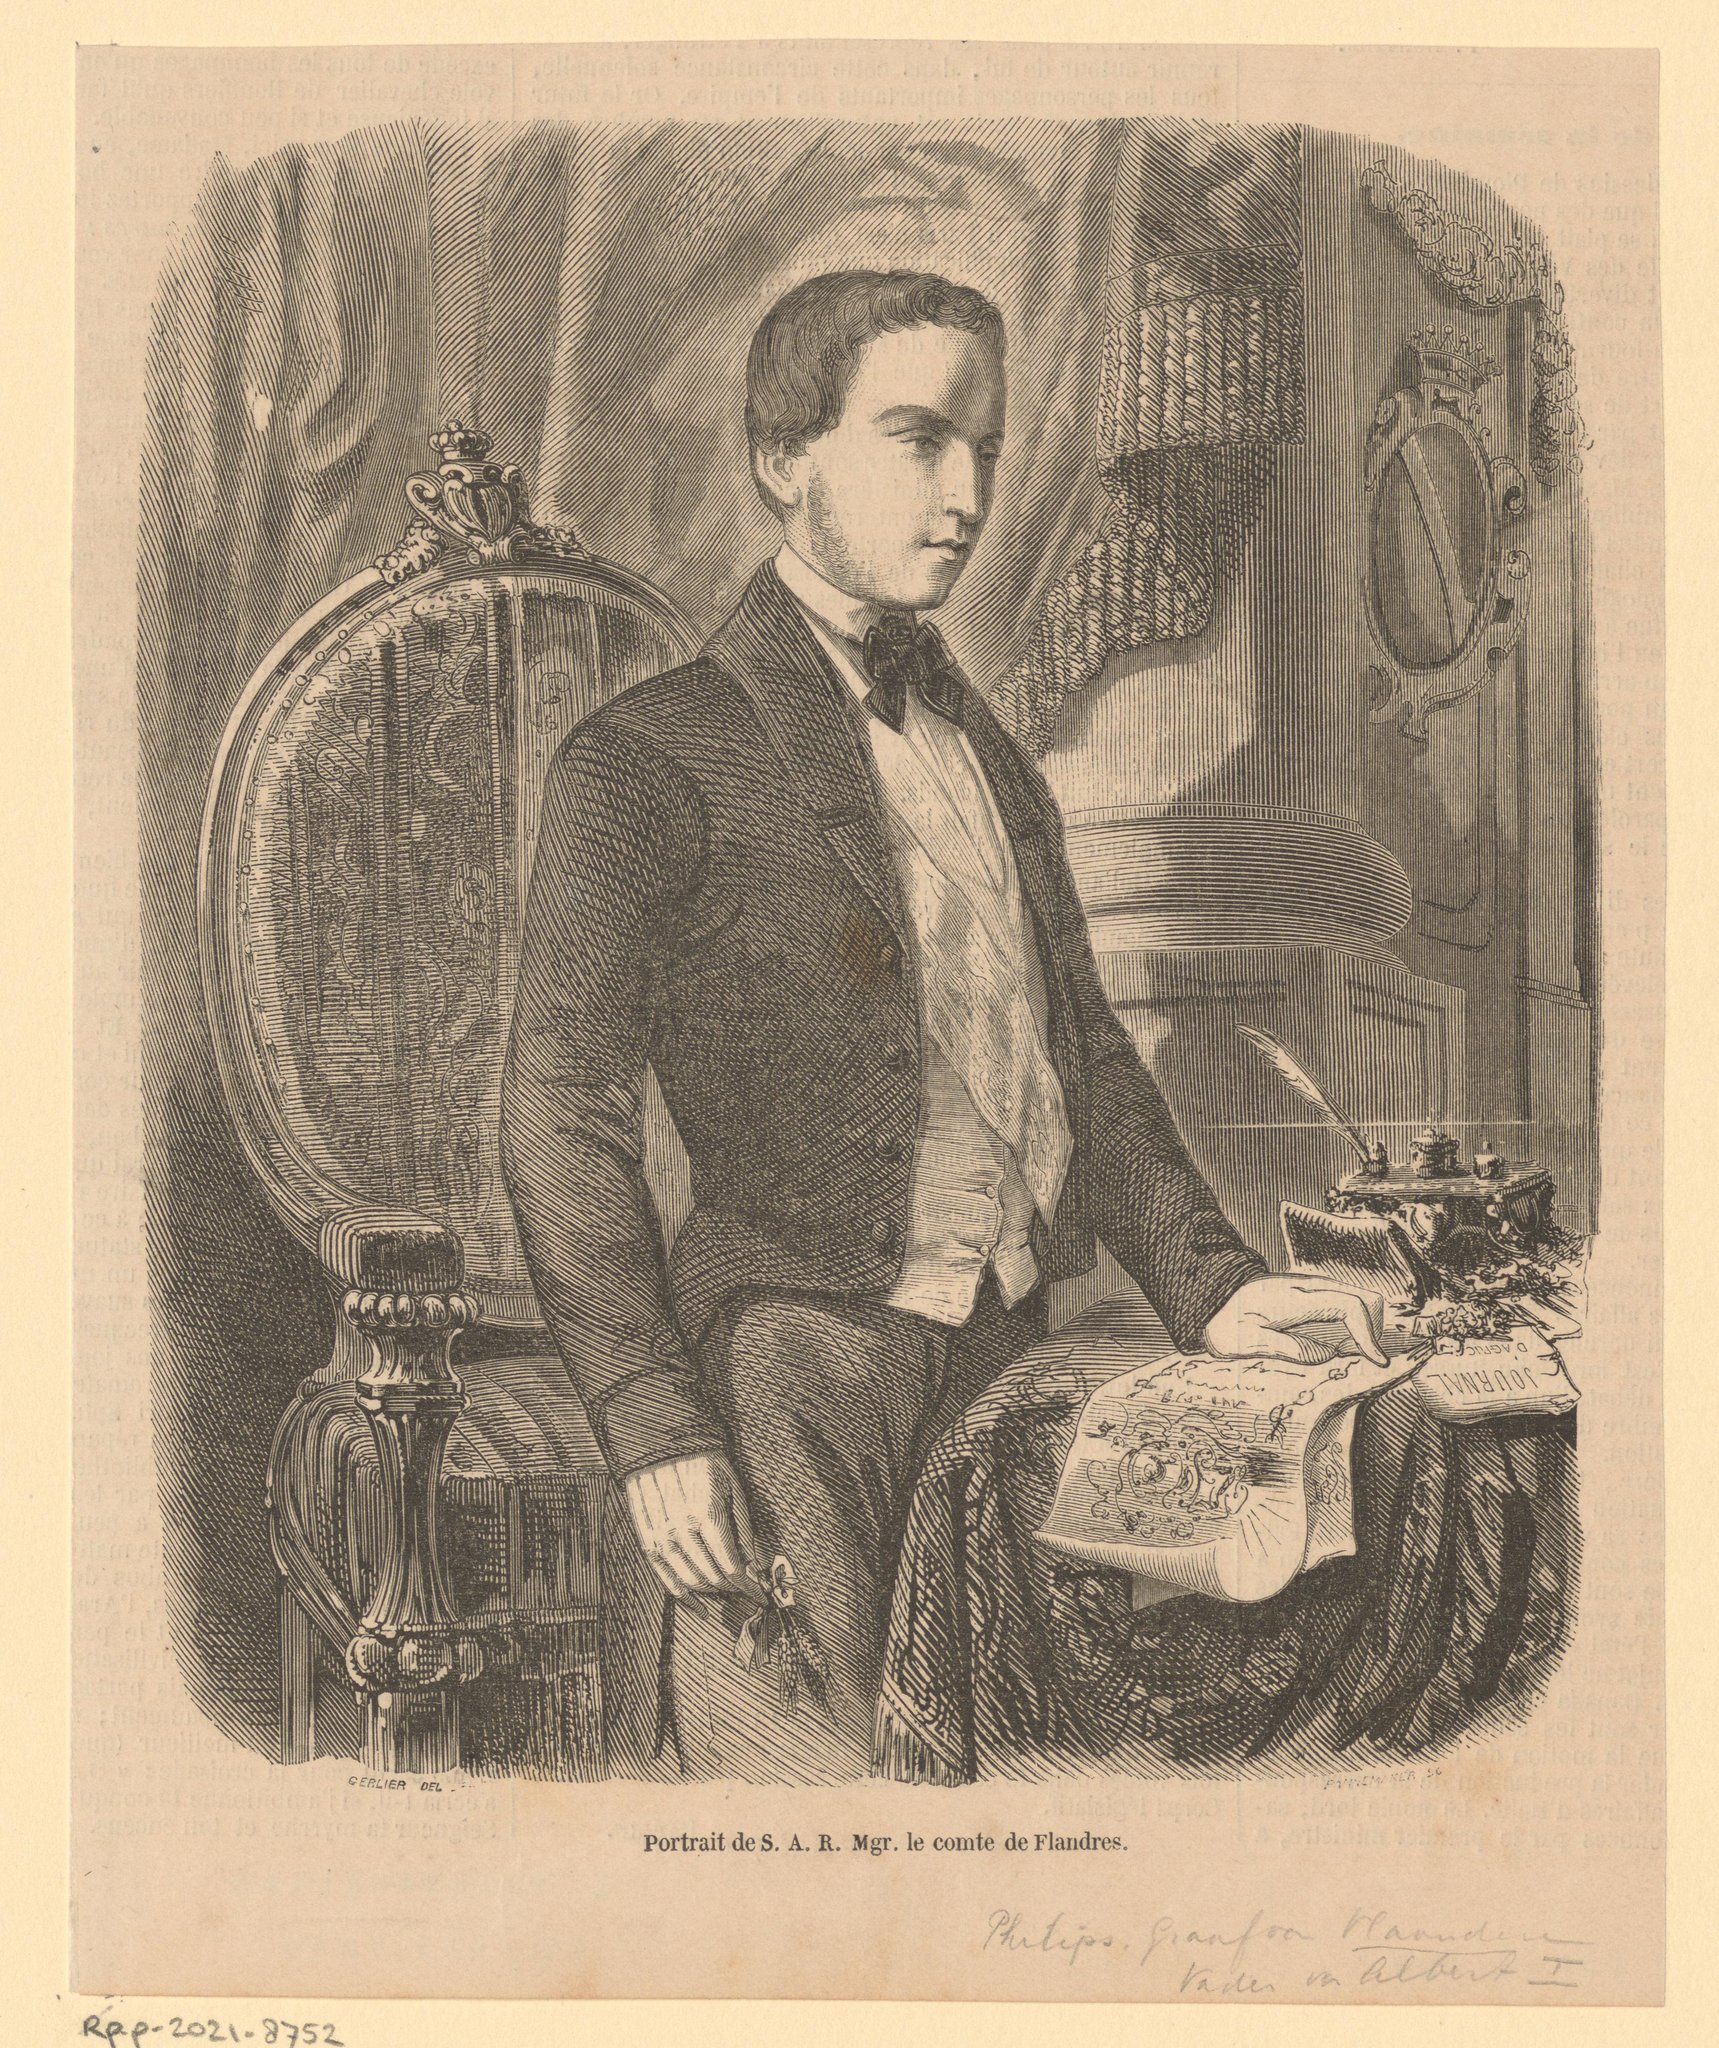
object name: print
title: Portret van Filips van België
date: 1856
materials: paper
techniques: letterpress printing, engraving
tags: laeken, adult man, historical persons, writing accessories, chair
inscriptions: stamp: ‘L'illustration 19 juli, 1856’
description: Prent uit: L'illustration, journal universel 28 (1856), nr. 699, 19 juli 1856.